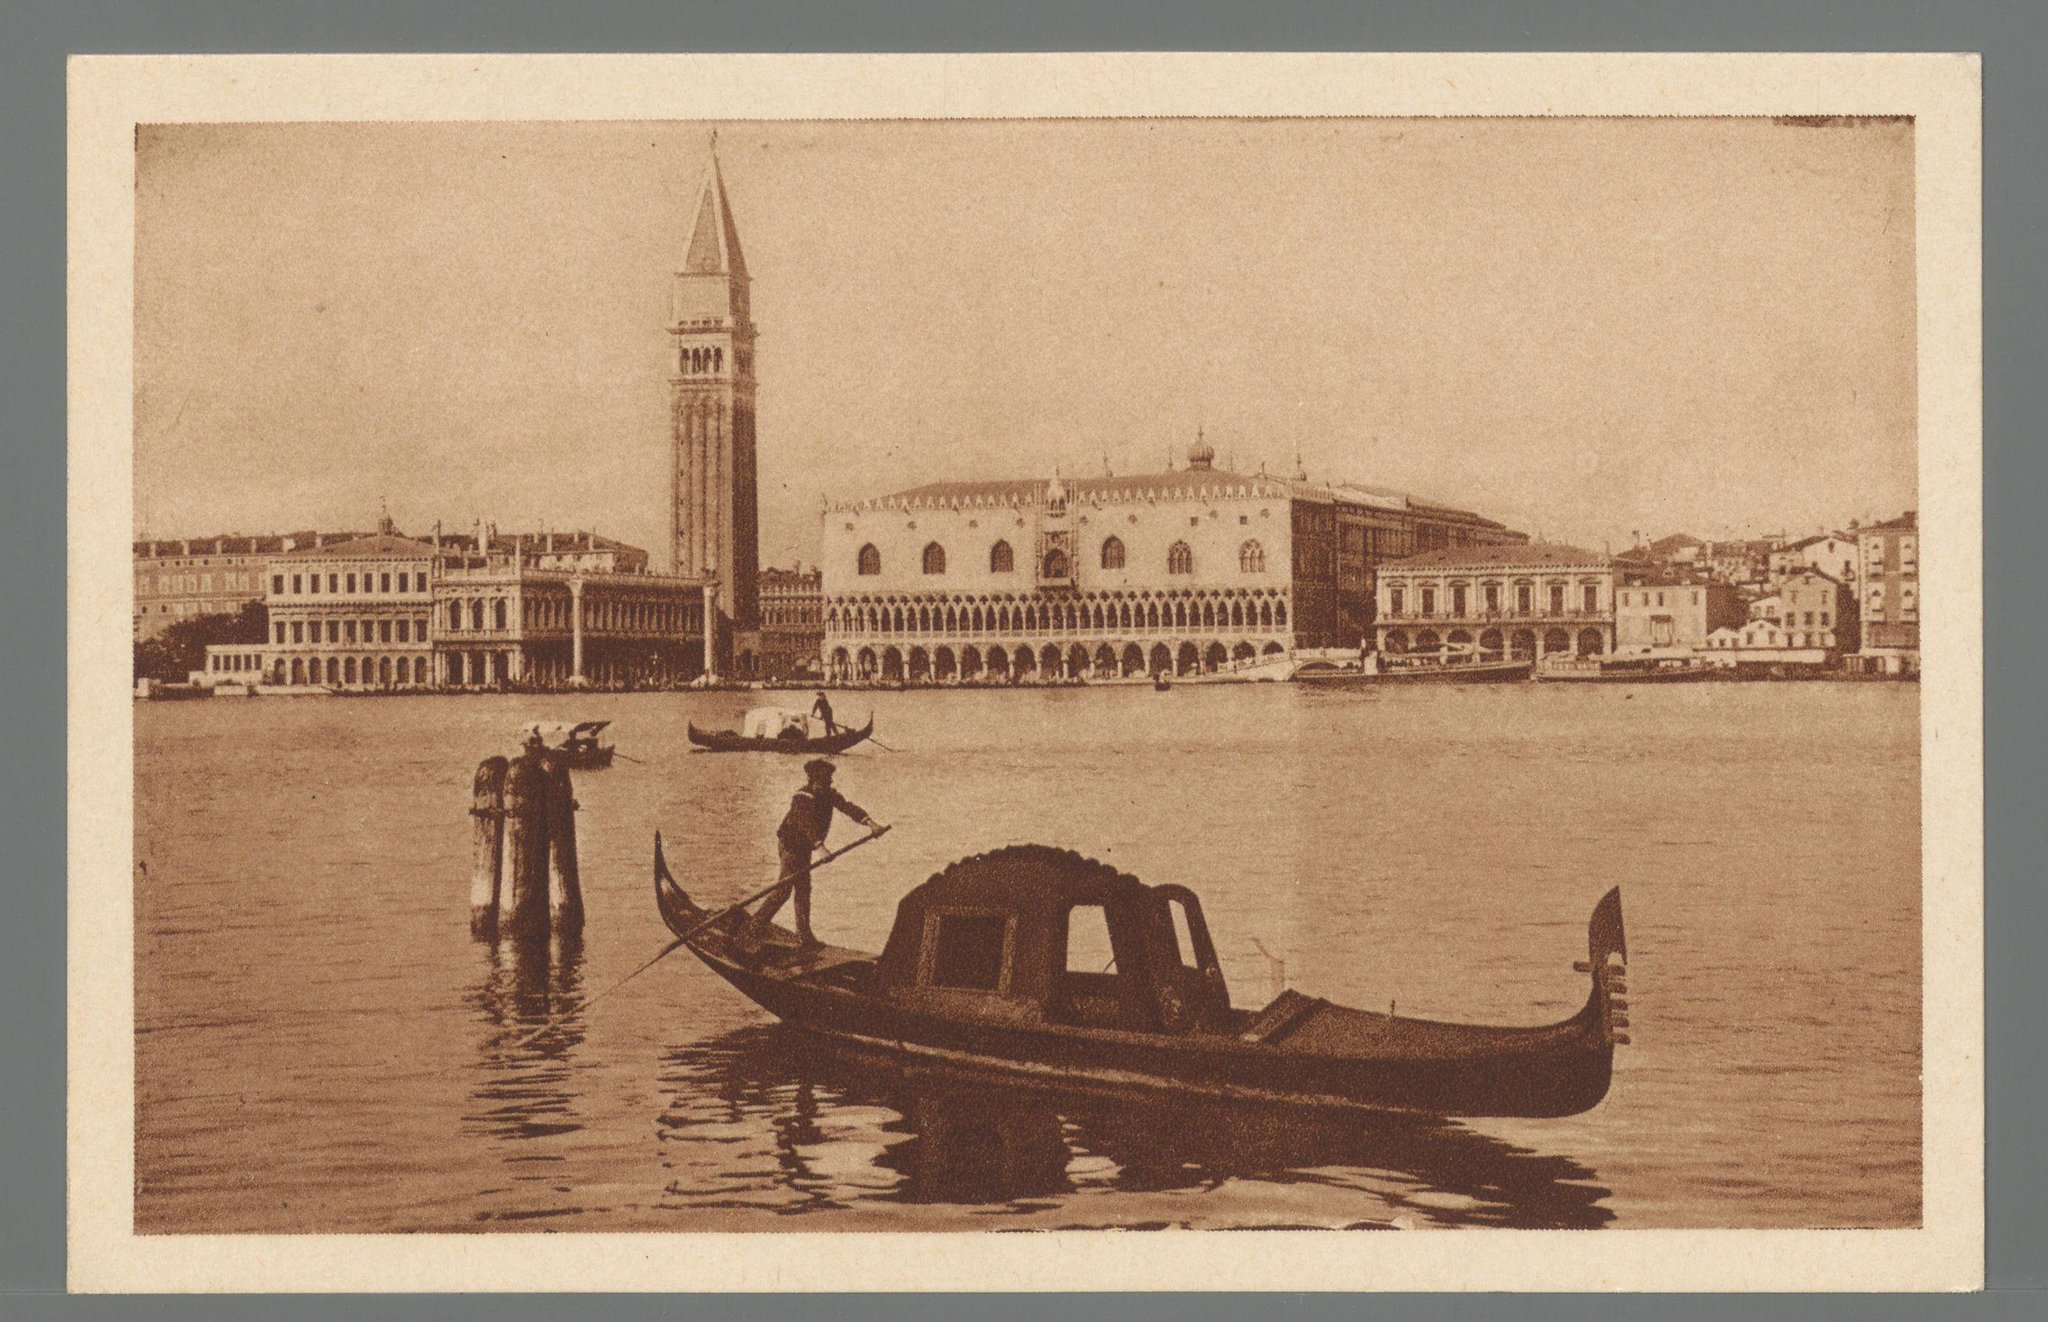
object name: ansichtkaart, prentbriefkaart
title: Venezia. Panorama dall'Isola S. Giorgio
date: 1906-1930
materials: cardboard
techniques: rotogravure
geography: venice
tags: gondola, city-view, and landscape with man-made constructions (+ city(-scape) with figures, staffage), venice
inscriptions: collector's mark: ‘AFE v S’